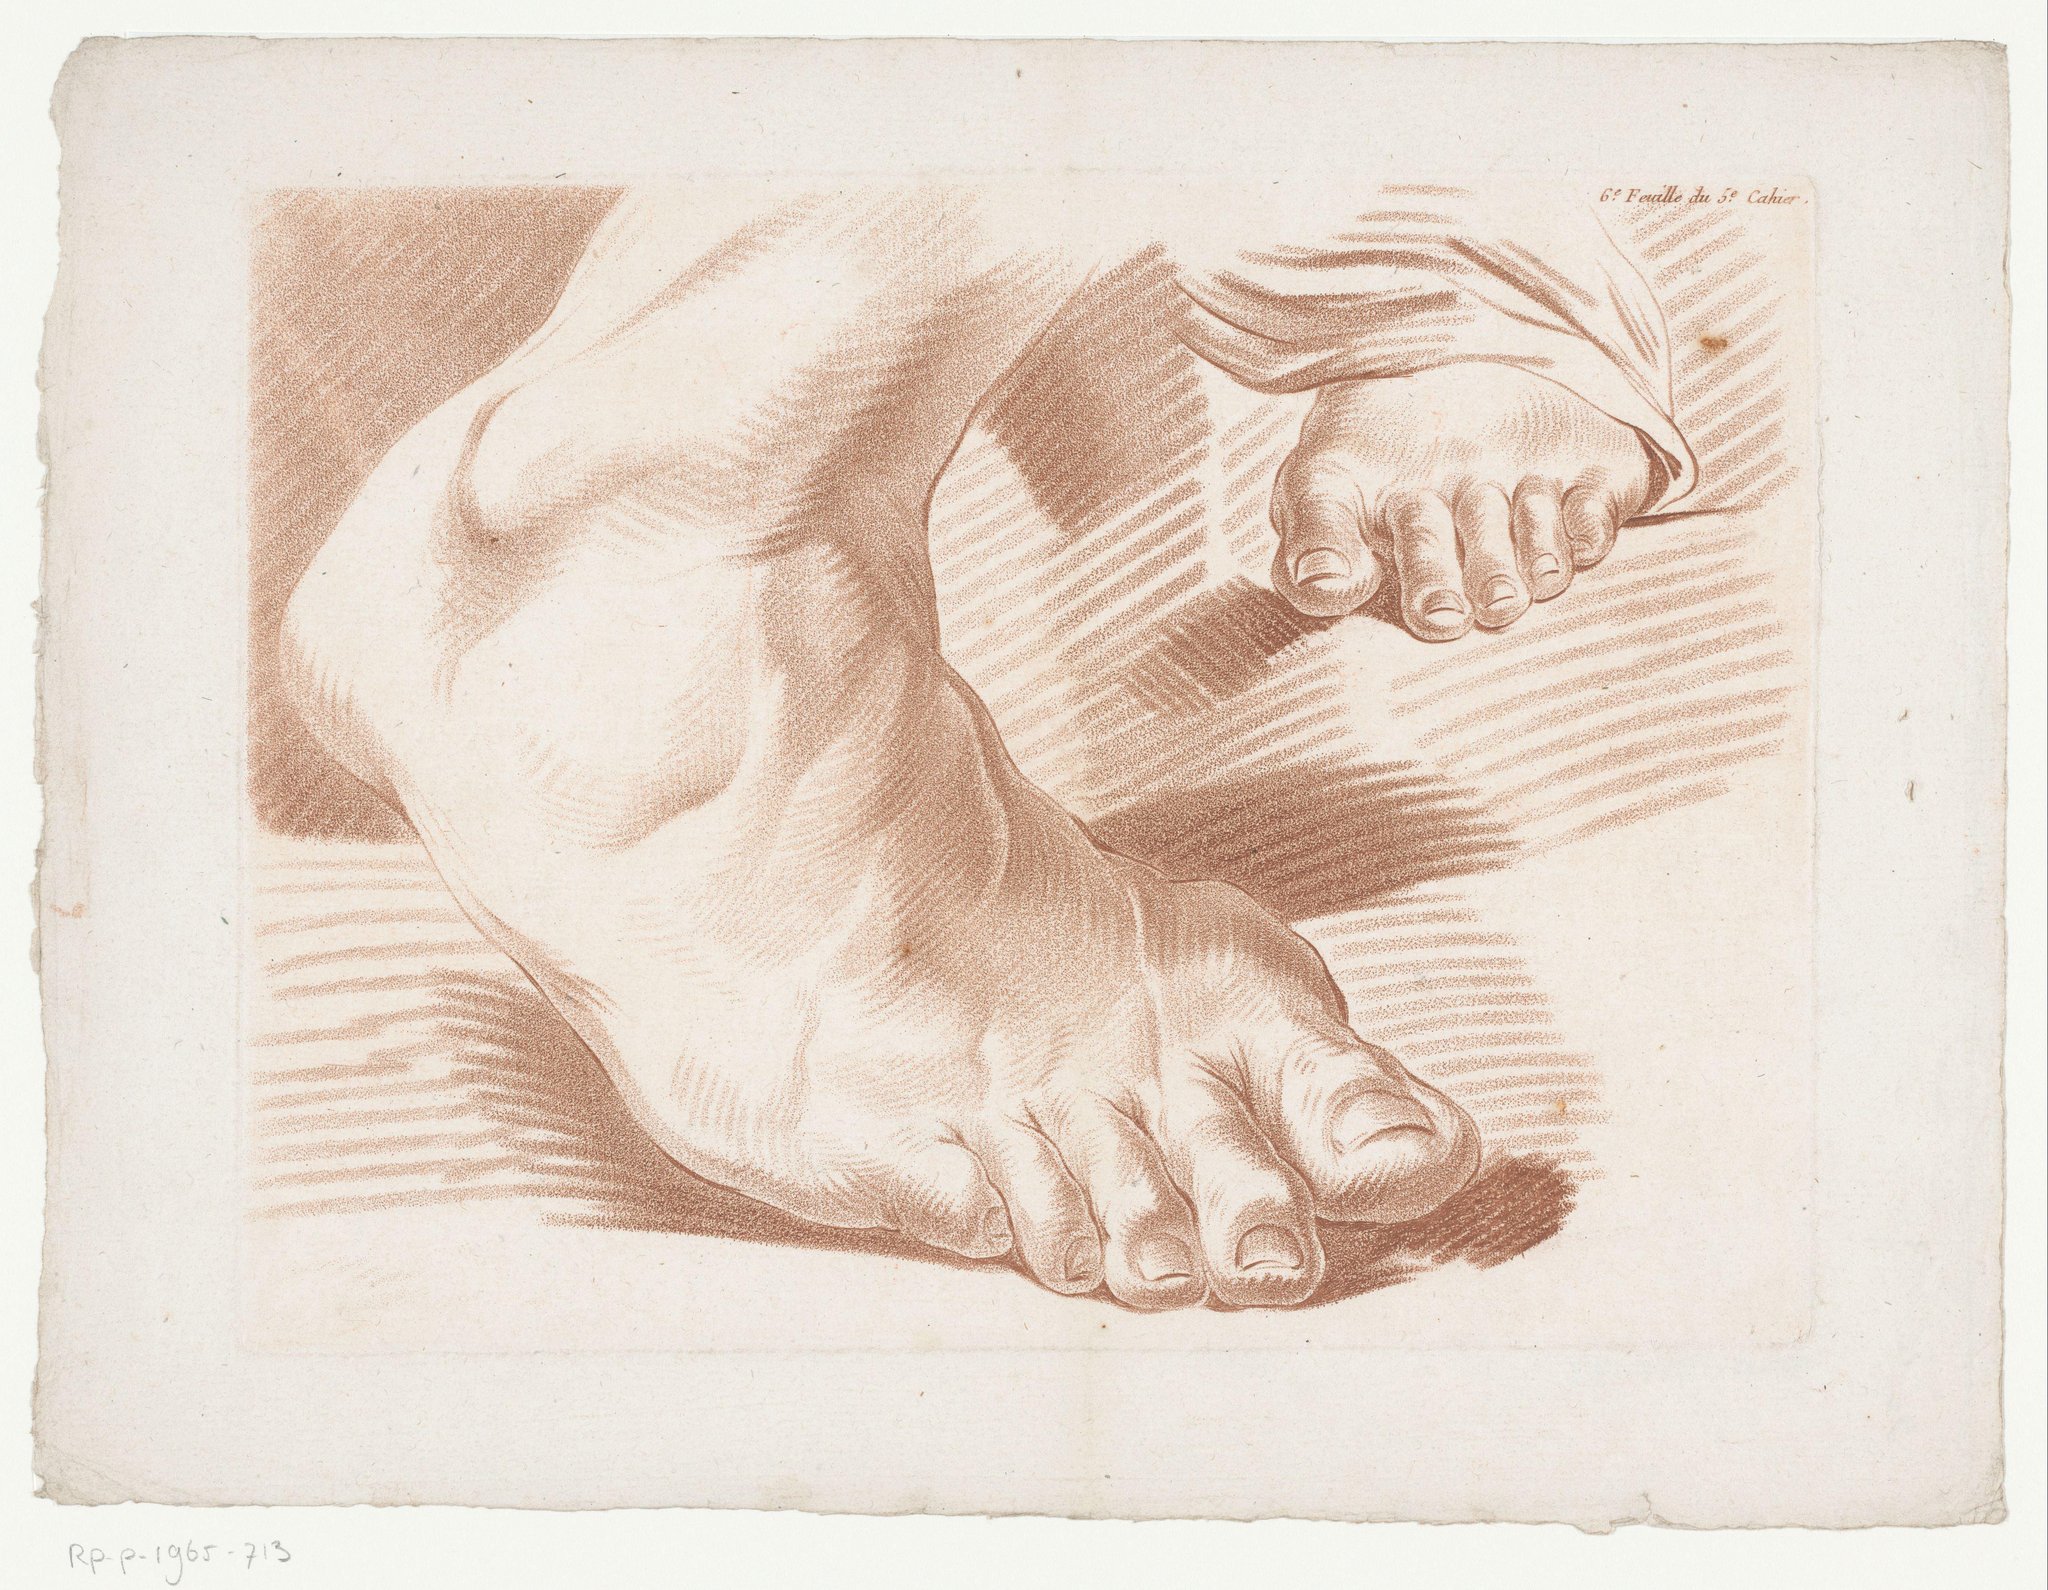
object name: print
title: Cinquième Cahier de Principes de Dessein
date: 1773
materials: paper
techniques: printmaking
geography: paris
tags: foot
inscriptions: collector's mark: Lugt 2228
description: Deze prent maakt deel uit van een album dat uit minstens elf delen bestaat. Dit is het zesde blad uit het vijfde album. Waarschijnlijk dienden deze albums als voorbeeld voor tekenaars, schilders en graveurs.